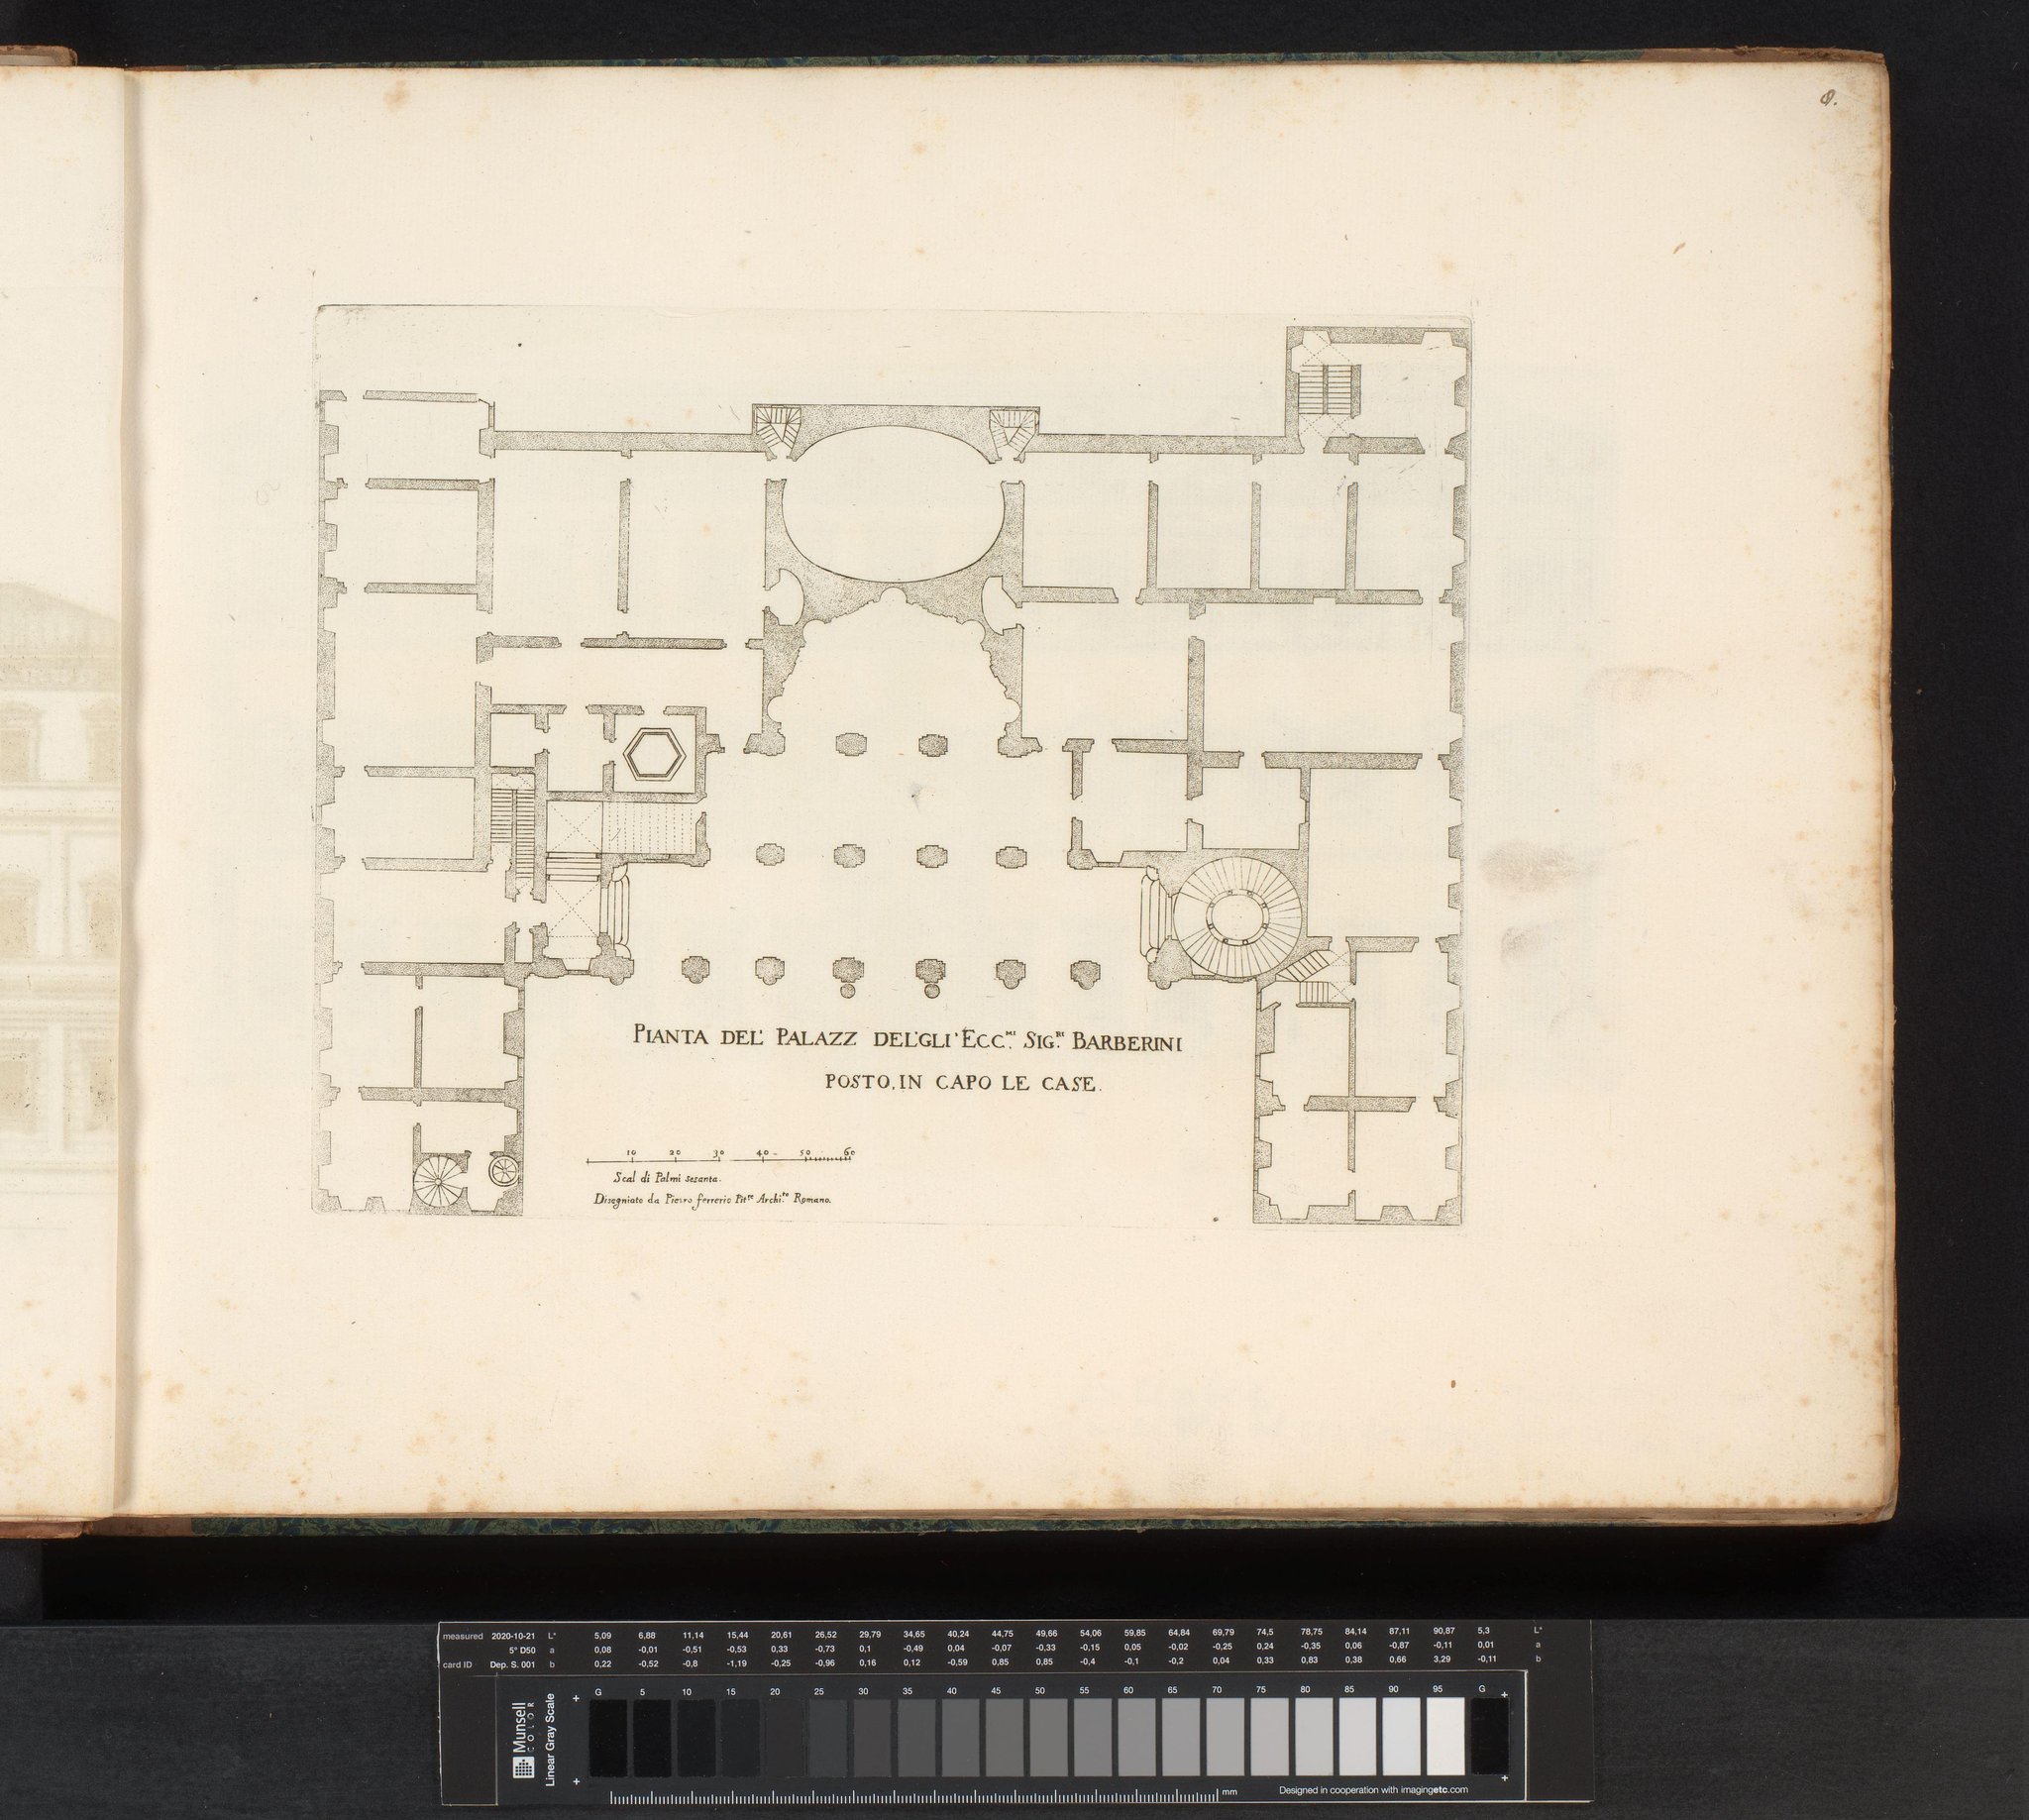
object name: print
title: Pianta del' palazzo degli ecc.mi sig.ri Barberini posto in Capo le Case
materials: paper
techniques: etching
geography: italy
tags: palace, plan ~ architecture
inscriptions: number: ‘8’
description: Deze prent maakt deel uit van de reeks getiteld: Palazzi di Roma. Deze reeks bestaat uit twee boeken. Boek één getiteld: Palazzi di Roma dei più celebri architetti..., bestaat uit 44 prenten die worden toegeschreven aan Giovanni Battista Falda (naam staat enkel op prent 27) en uitgegeven door Giovanni Giacomo de'Rossi. Deze 44 prenten zijn bekend in twee staten (met en zonder nummer). Boek twee getiteld: Nuovi disegni dell'architetture... libro secondo, bevat 66 prenten door Giovanni Battista Falda en Simone Felice. Deze 66 prenten zijn bekend in twee staten (met en zonder nummer).